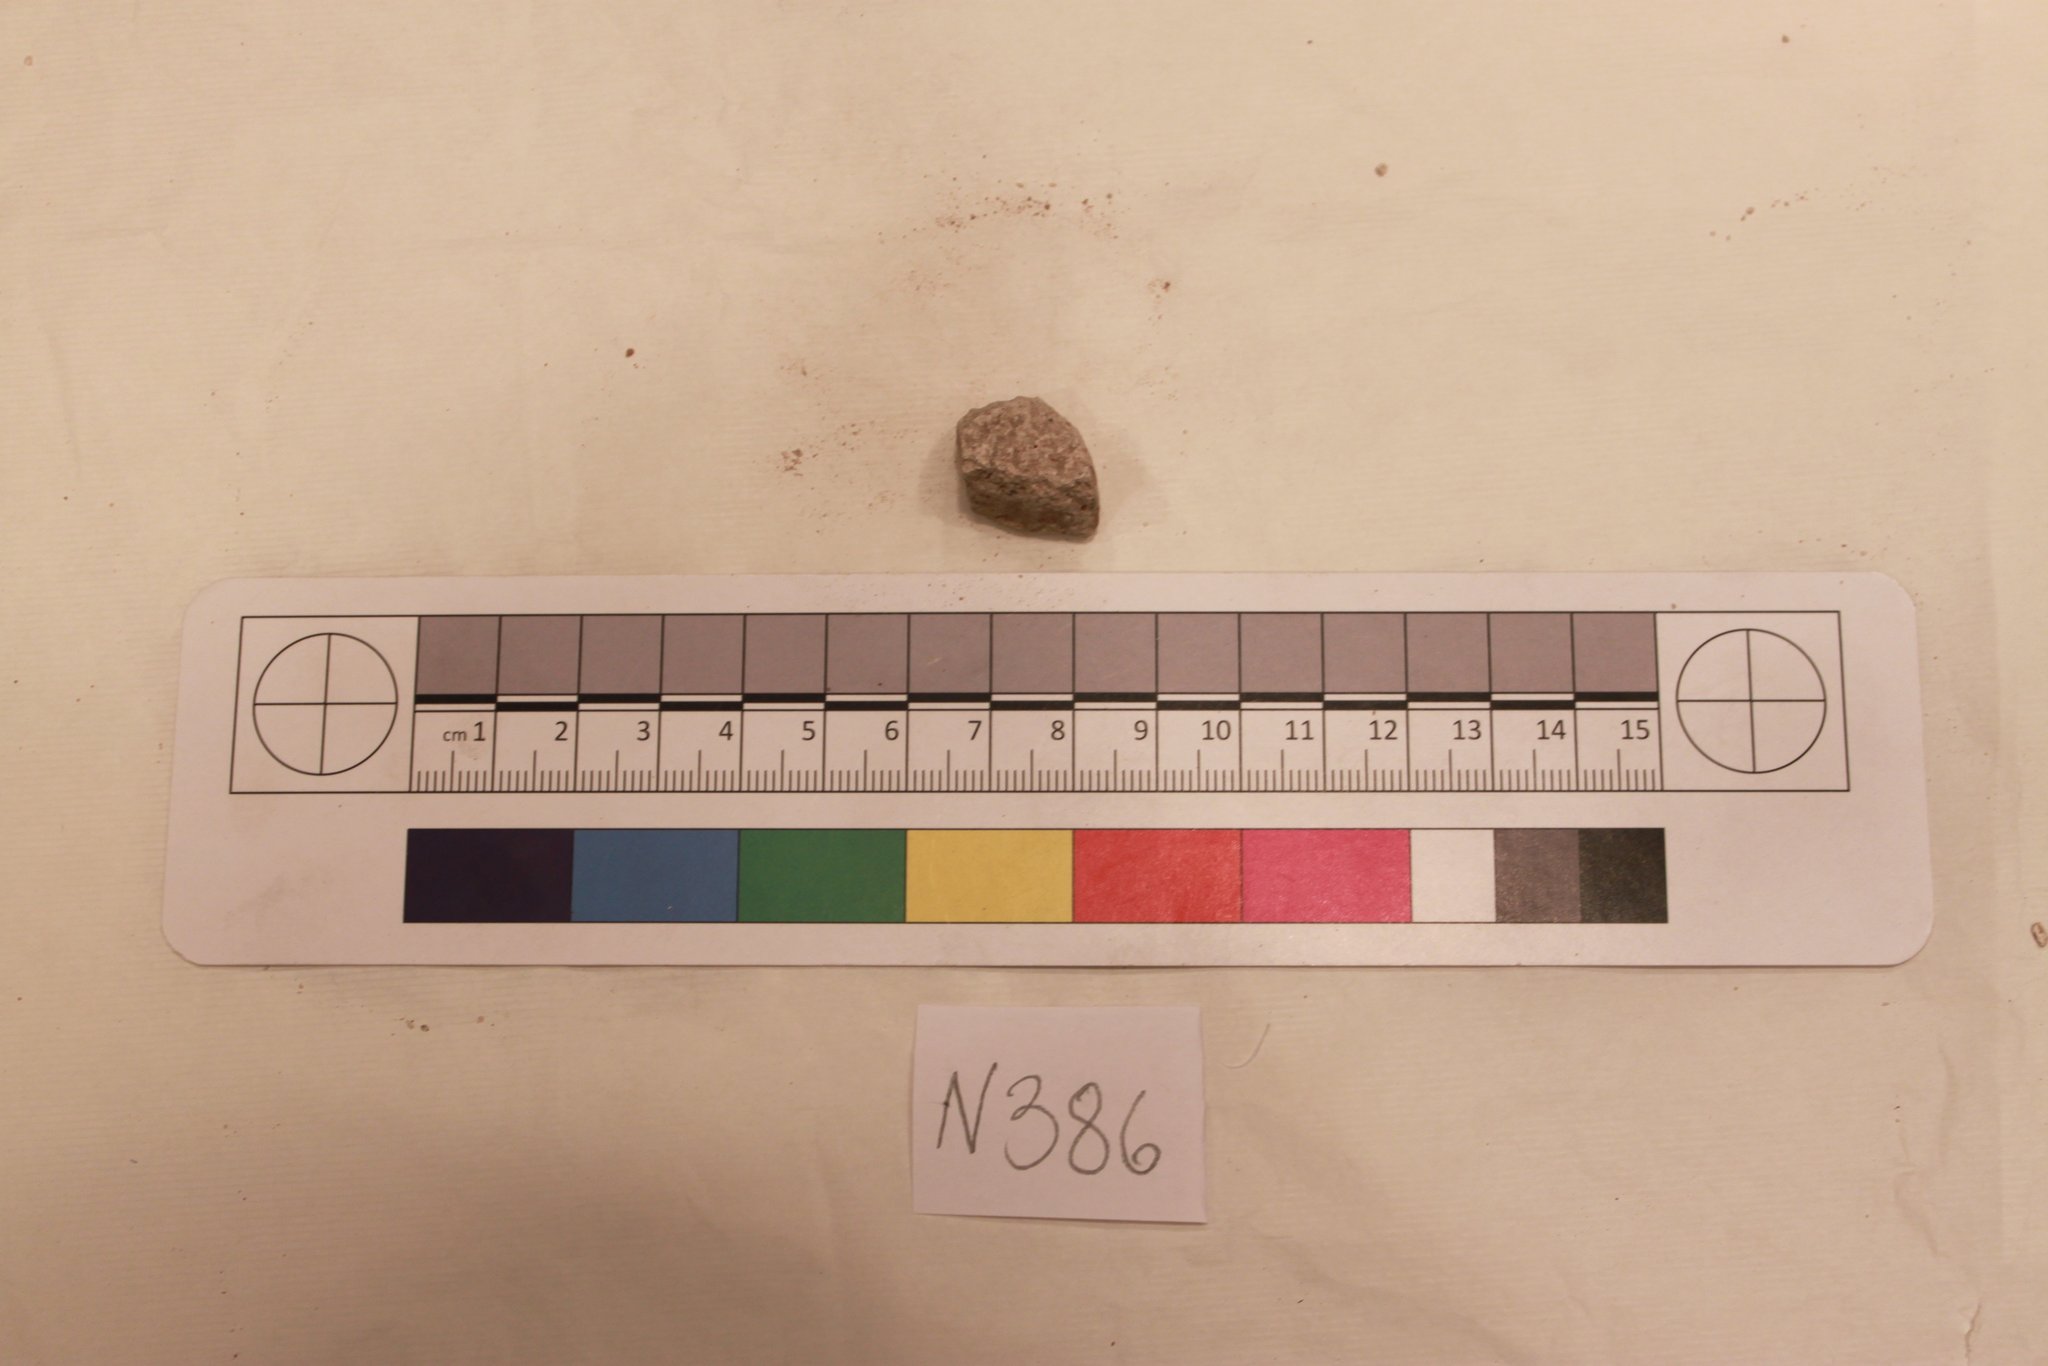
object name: fragment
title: Stucco Fragment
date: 701-1200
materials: plaster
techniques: carving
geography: iran